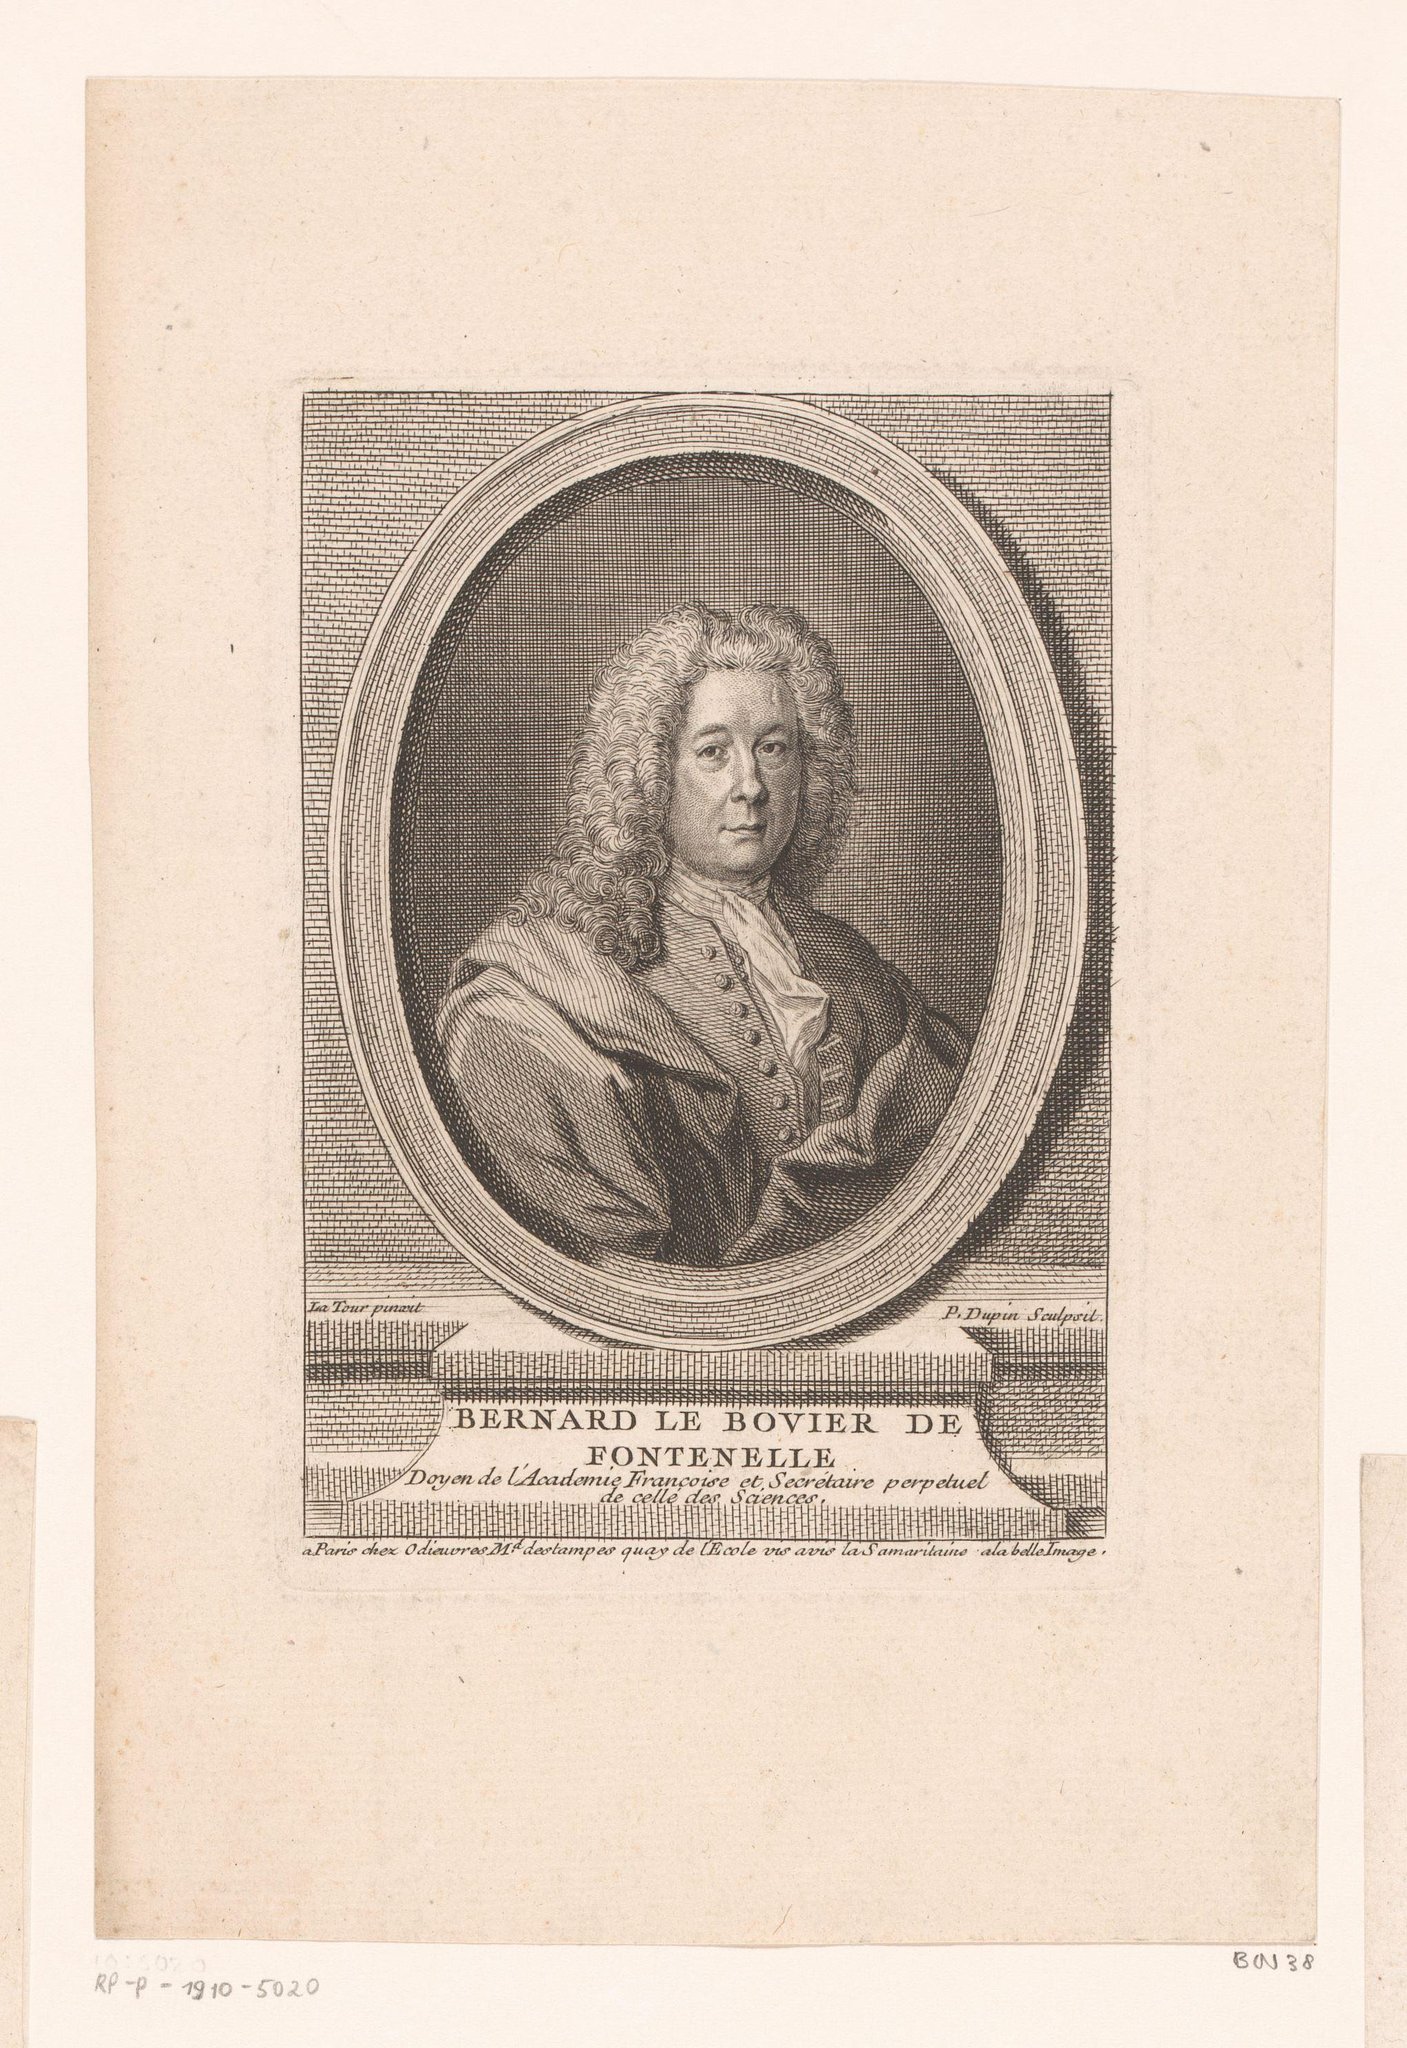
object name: print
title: Portret van Bernard le Bovier de Fontenelle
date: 1700-1751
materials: paper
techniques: engraving, etching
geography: france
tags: paris, scholar, philosopher, historical persons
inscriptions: collector's mark: Lugt 2228